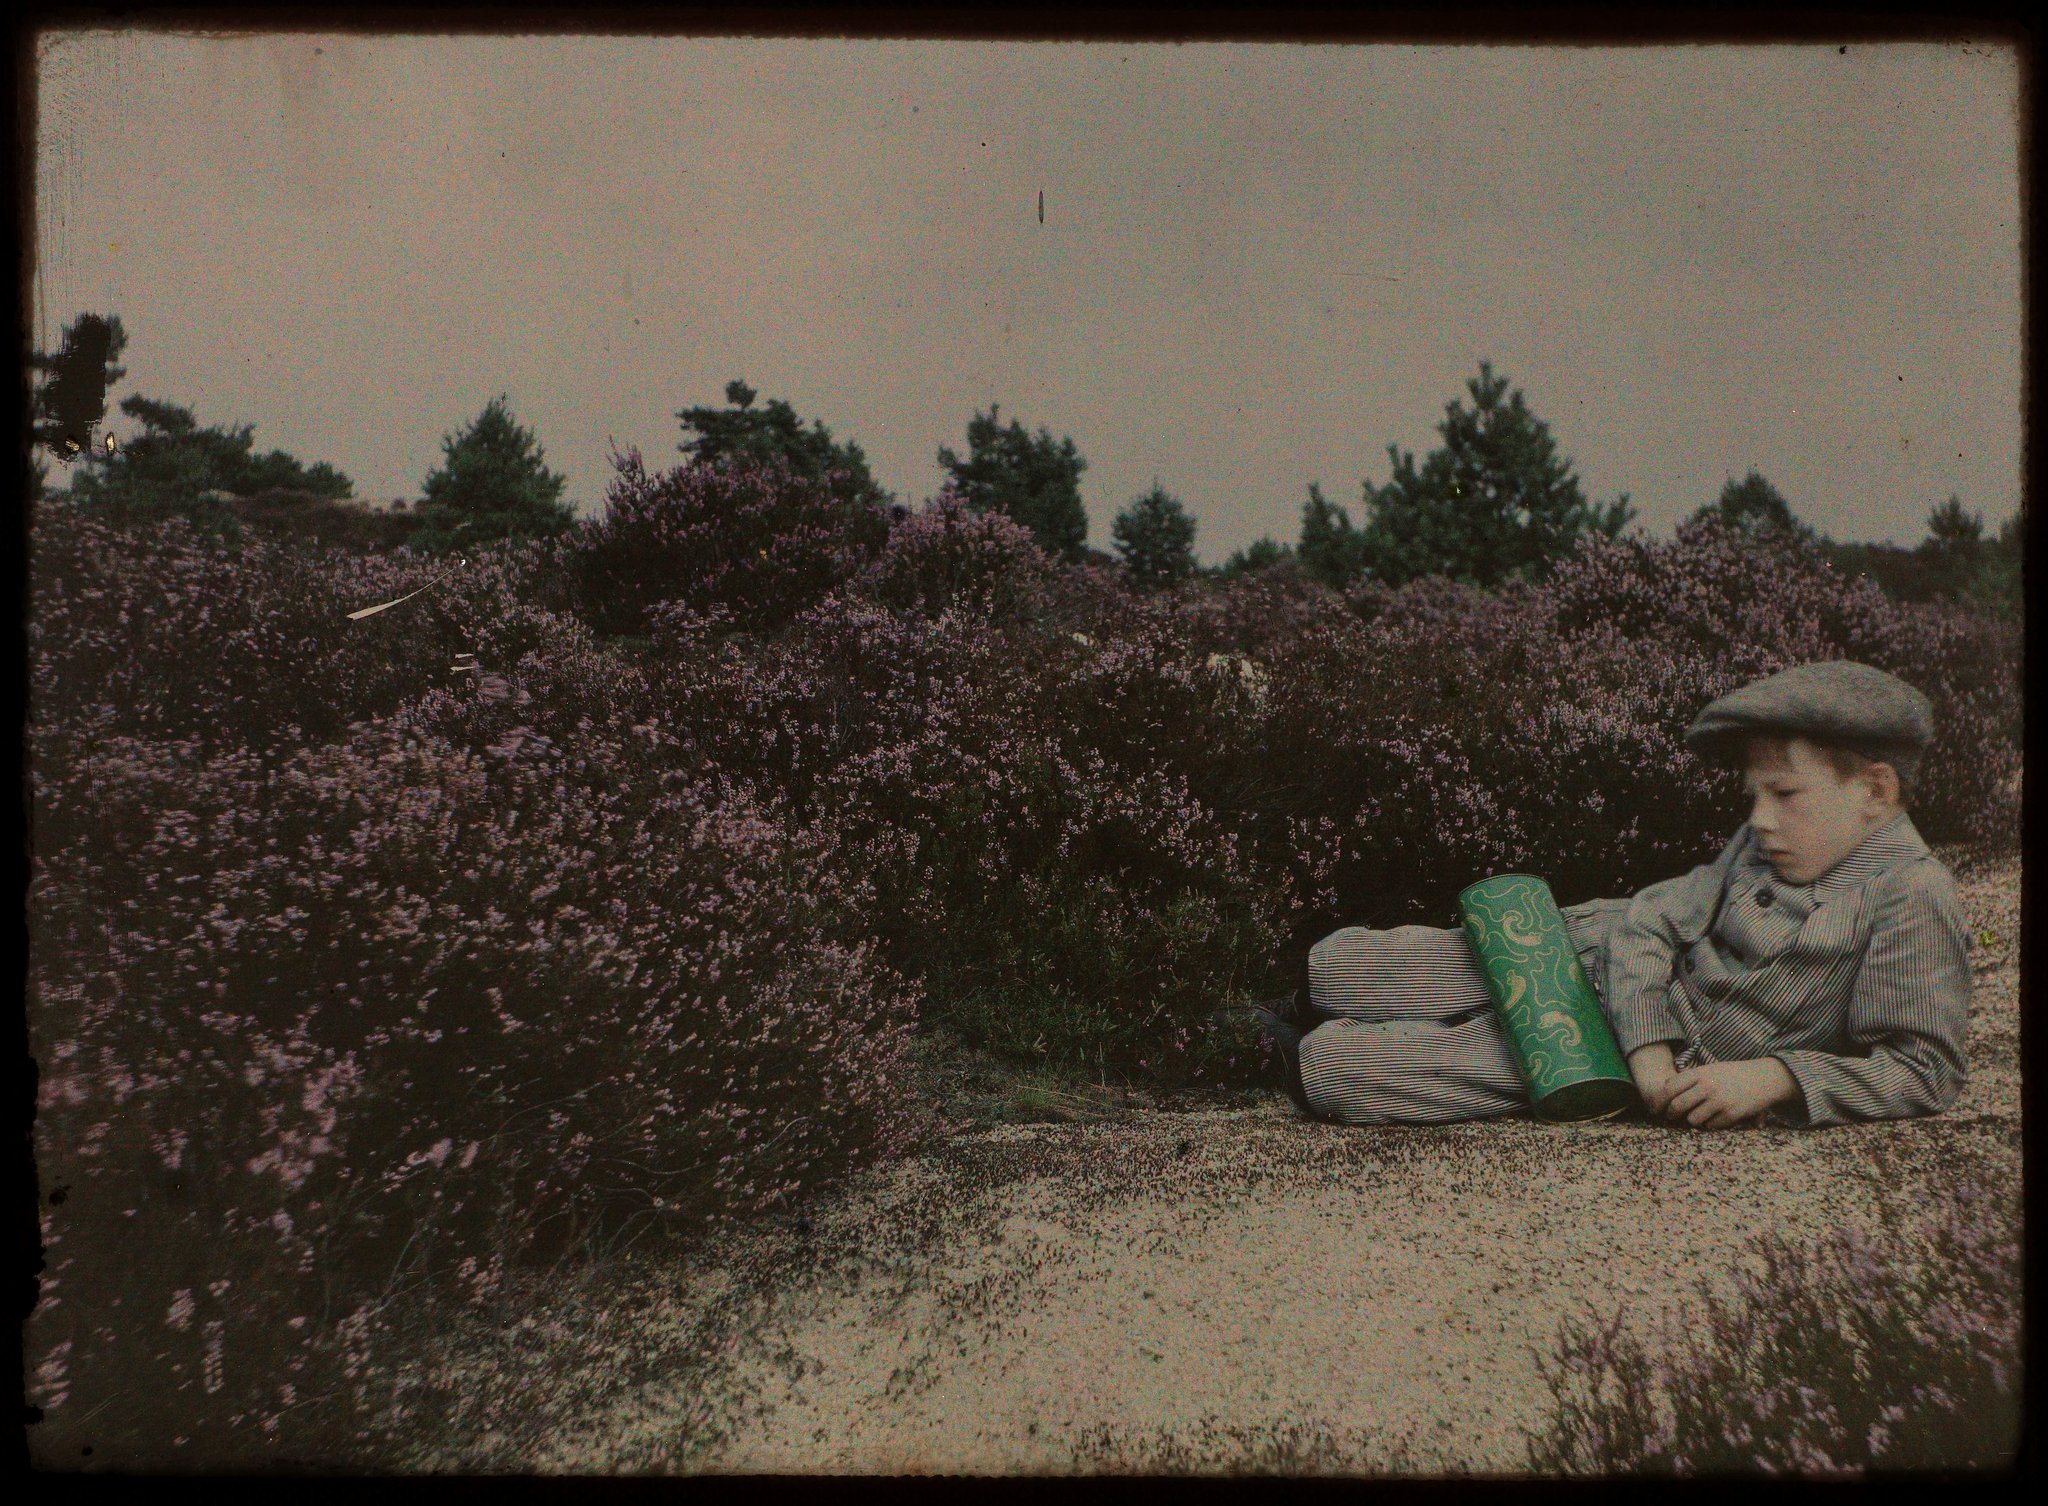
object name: photograph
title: Lambertus Hendrik van Berk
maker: lambertus hendrik van berk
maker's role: fotograaf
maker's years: 1869-1950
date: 1914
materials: glass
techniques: autochrome process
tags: boy (child between toddler and youth), historical persons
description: Lambertus Hendrik ('Hans') van Berk (1904-1973), zoon van de fotograaf, met botaniseertrommel liggend in de hei.